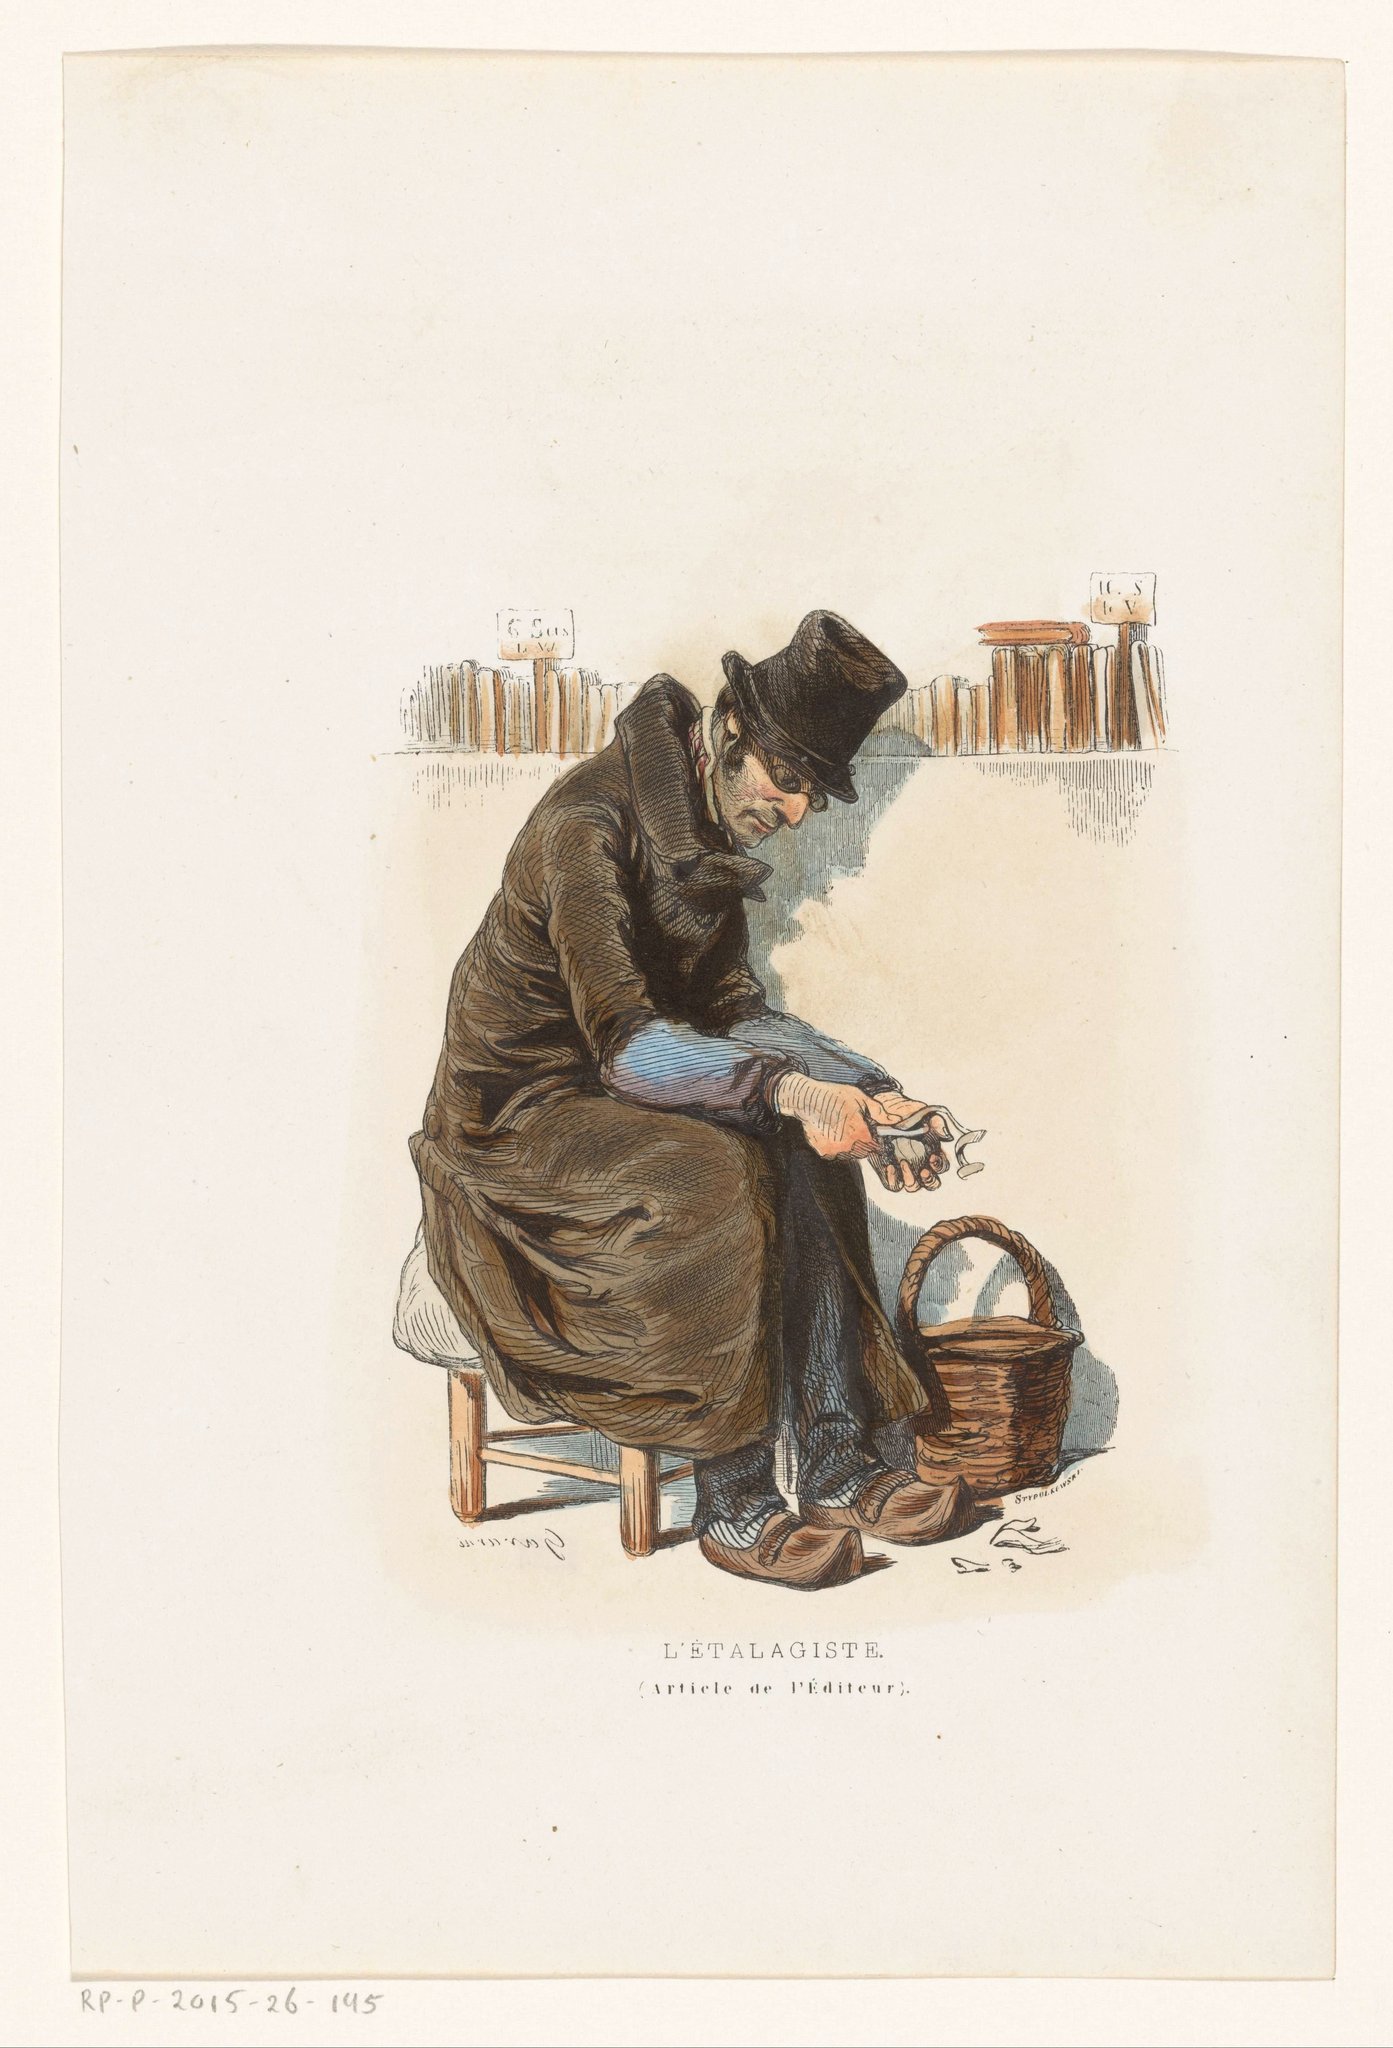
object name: print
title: L'Étalagiste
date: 1841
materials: paper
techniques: hand coloring, letterpress printing, engraving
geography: paris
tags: book-stall, kiosk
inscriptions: collector's mark: Lugt 2228, collector's mark: Lugt 4780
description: Prent ook gebruikt in: Les français peints par eux-mêmes: encyclopédie morale du dix-neuvième siècle. Dl. 4. Parijs: L. Curmer, 1841, tussen p. 324-325.